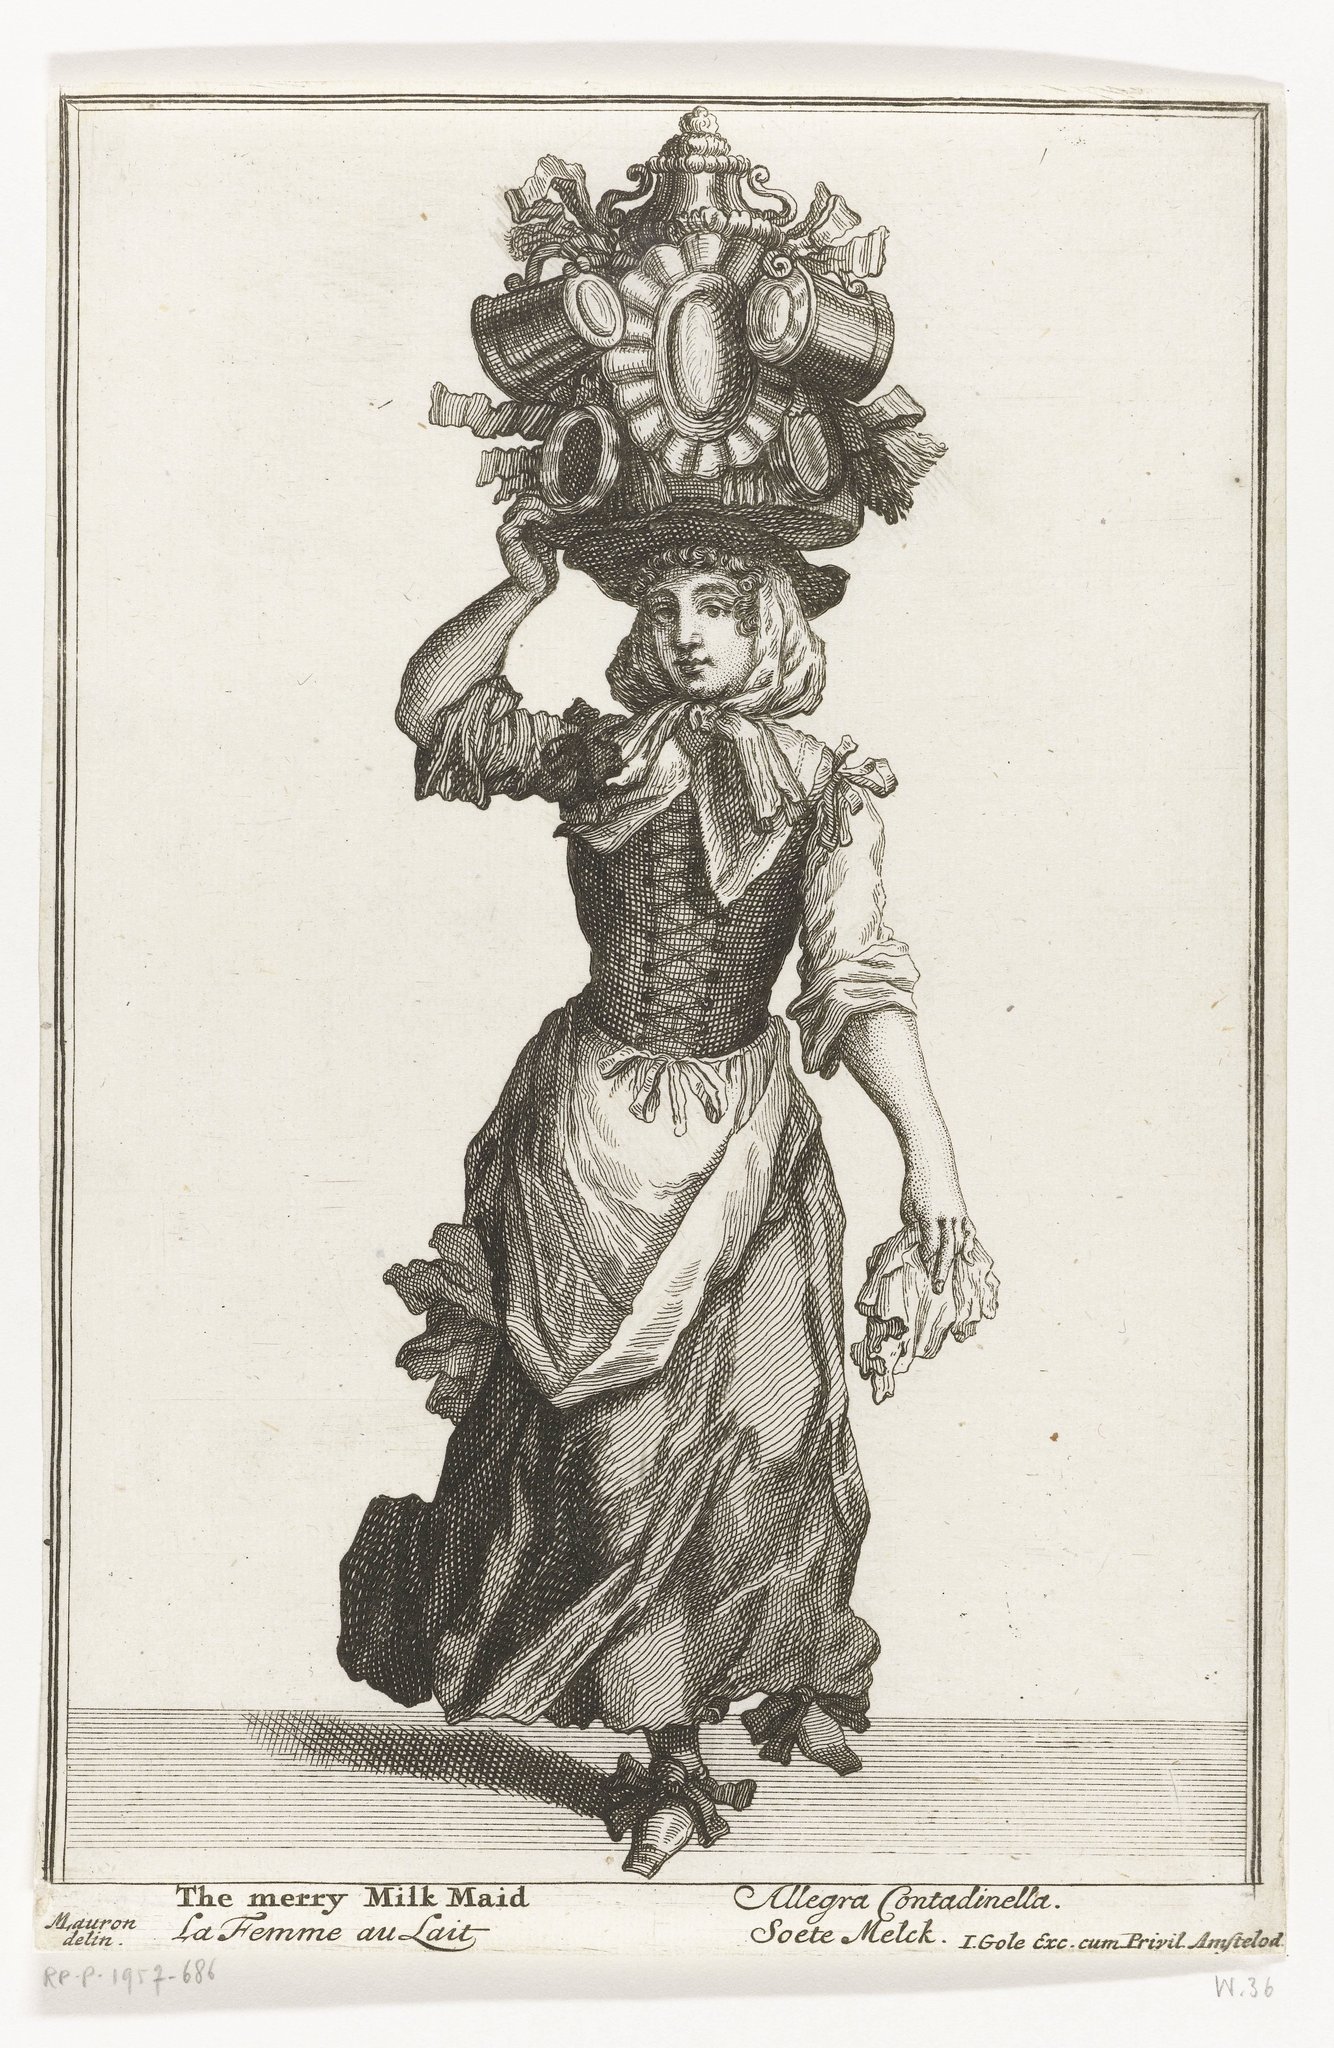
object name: print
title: Melkmeid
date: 1688-1724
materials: paper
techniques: engraving, etching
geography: amsterdam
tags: milkmaid, 'cris de paris', cries of london, etc. - bb - women engaged in trade and commerce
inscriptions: collector's mark: Lugt 2228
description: Een meisje met een ornamentaal melkvat op haar hoofd, waaraan bekers hangen. Ze verkoopt melk. De prent heeft een Engels, Frans, Italiaans en Nederlands onderschrift en maakt deel uit van een serie over de straatventers in Londen.